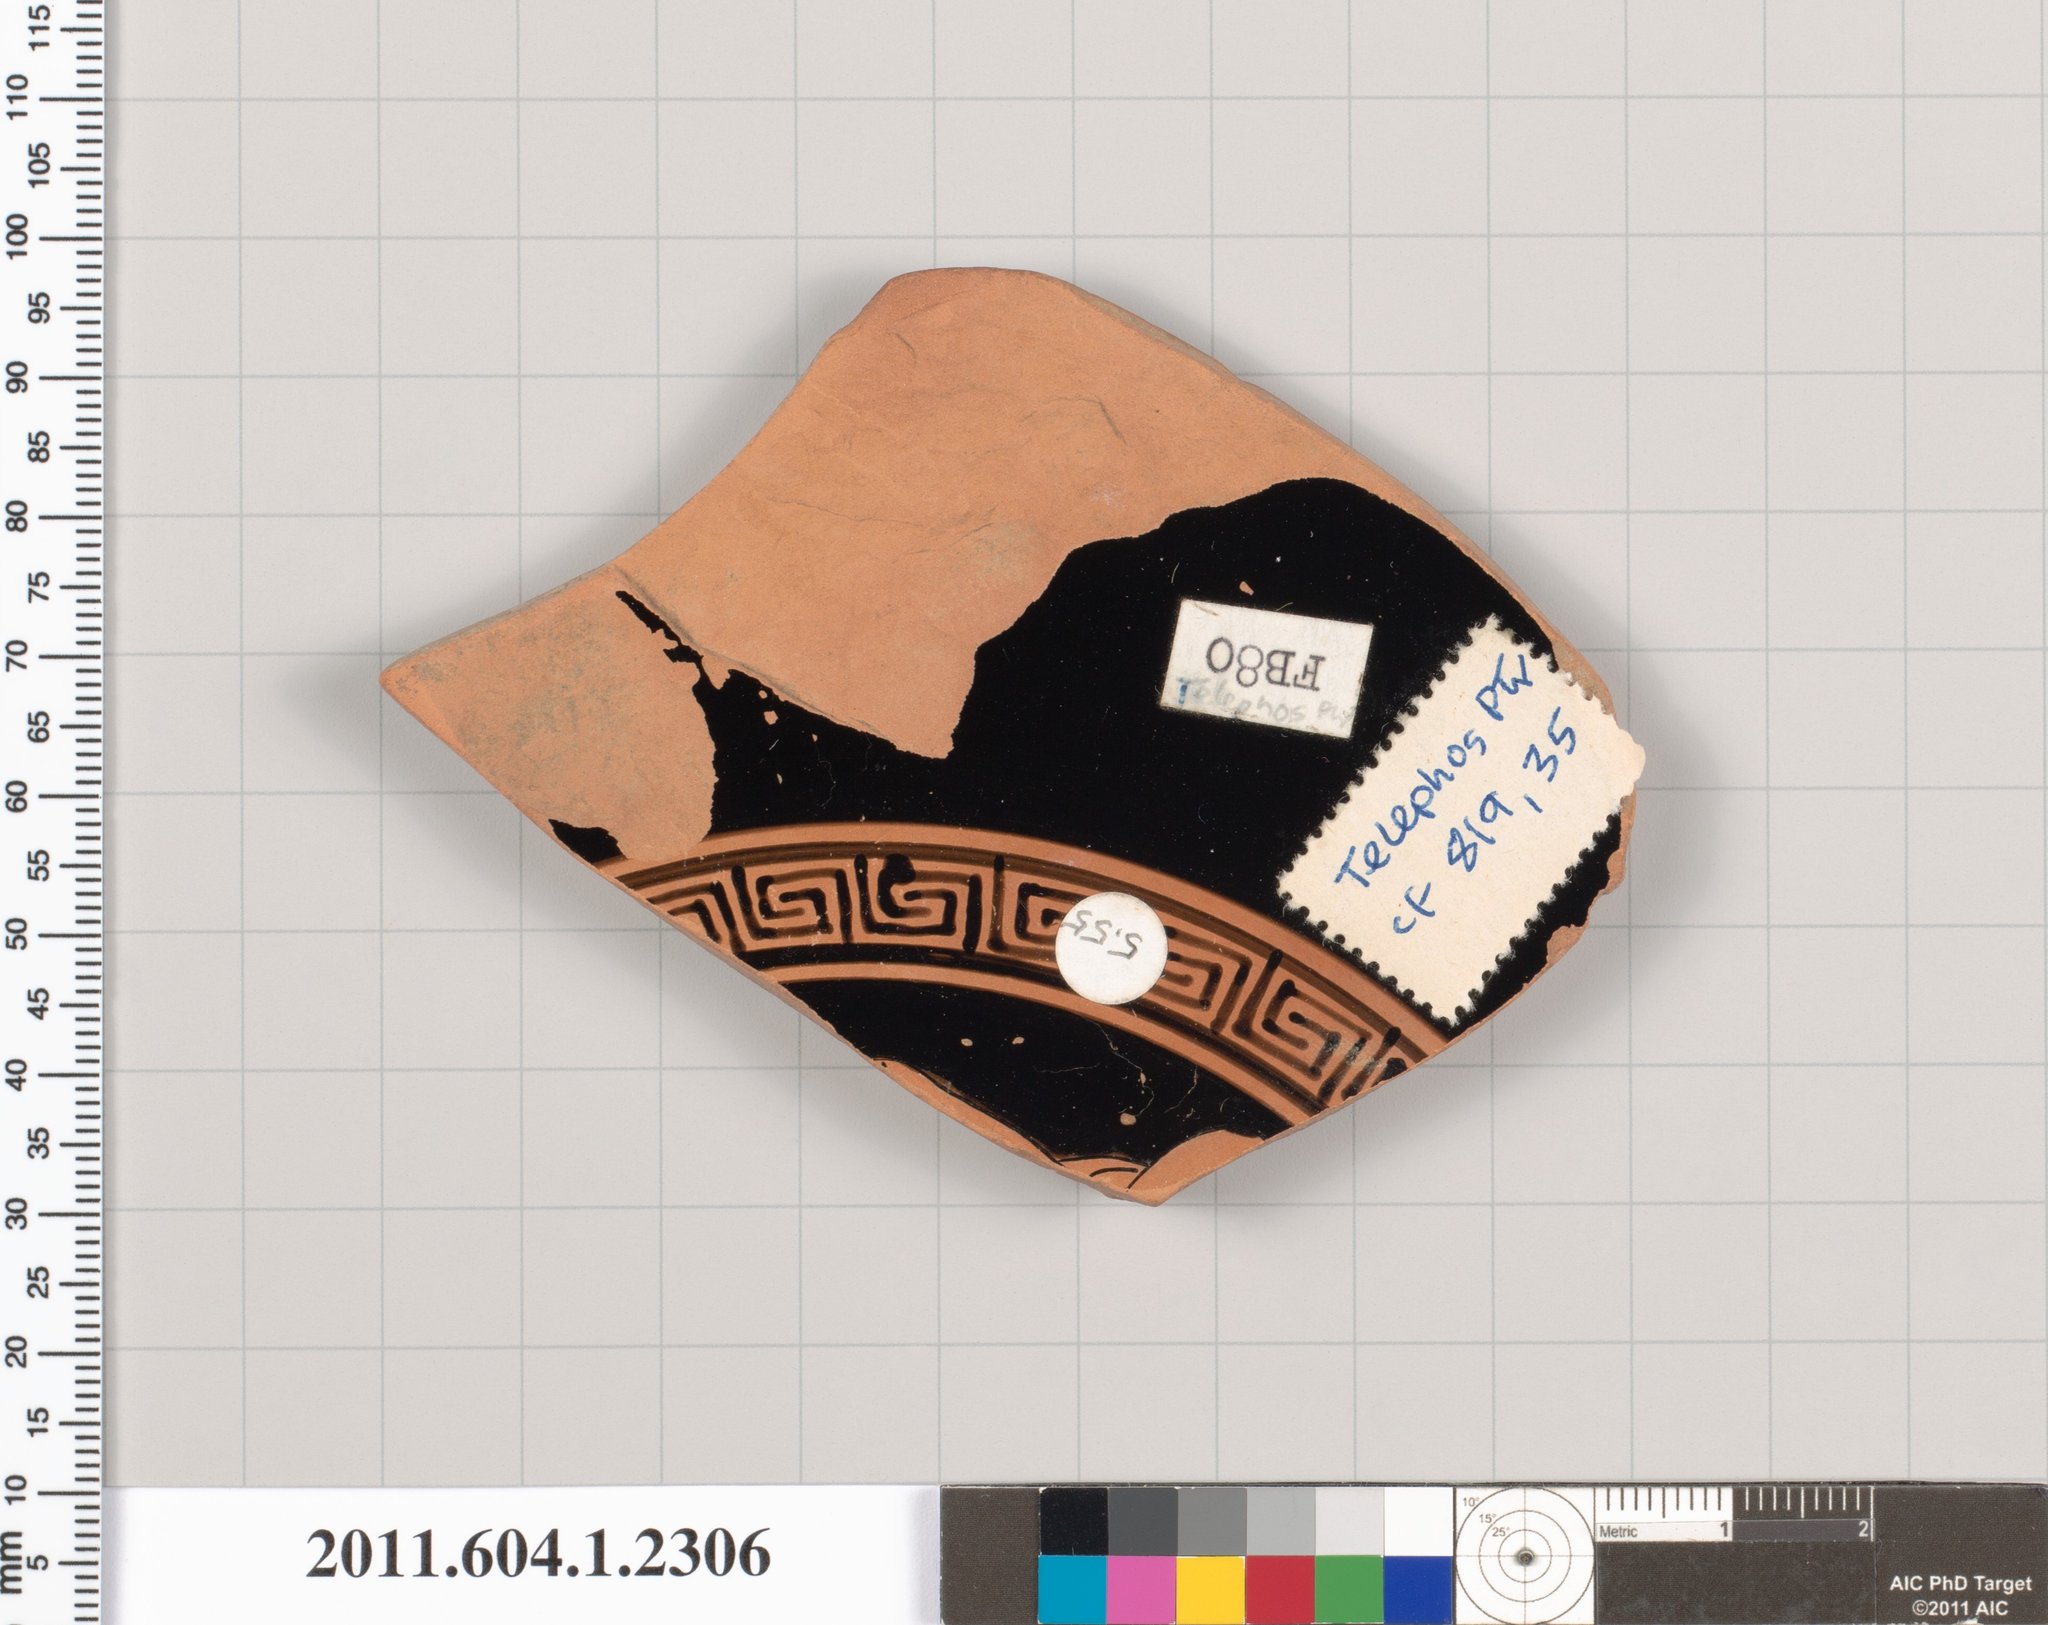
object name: kylix fragment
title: Terracotta fragment of a kylix (drinking cup)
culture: greek, attic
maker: telephos painter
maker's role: artist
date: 480-470 BCE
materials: terracotta